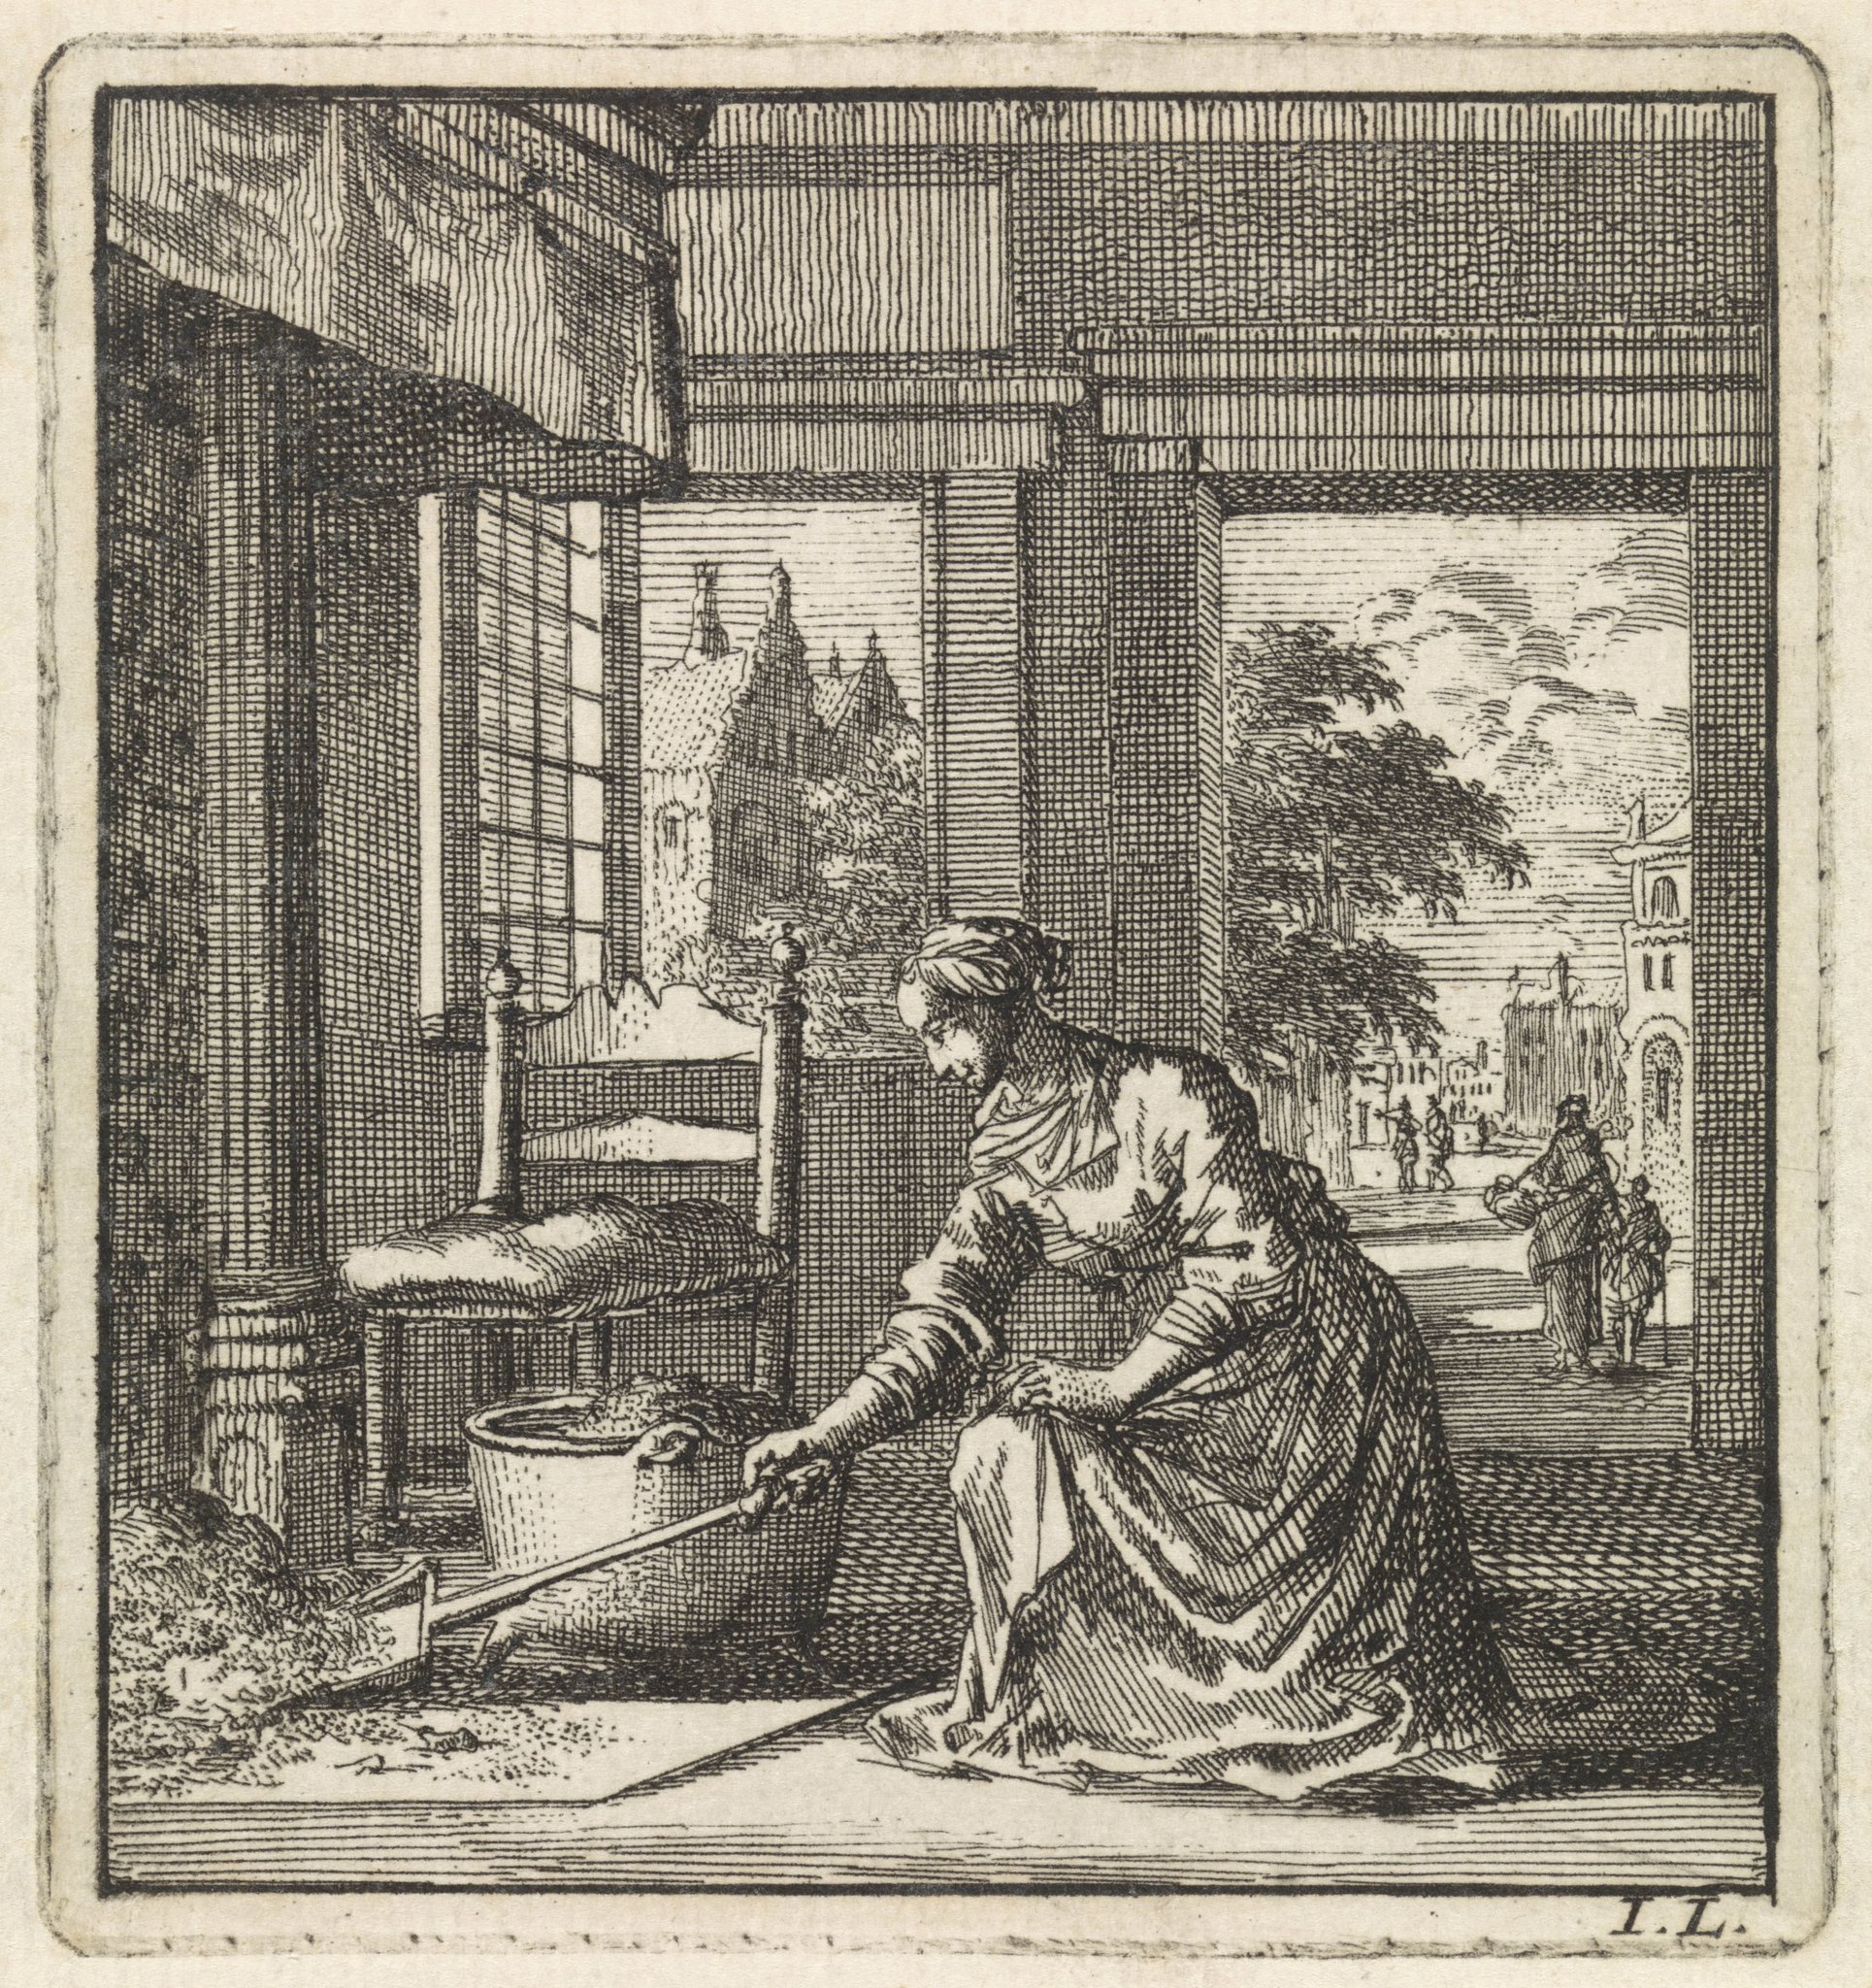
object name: book illustration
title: Vrouw schept de as uit de haard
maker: jan luyken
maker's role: draughtsman, print maker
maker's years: 1649-1712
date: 1711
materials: paper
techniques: etching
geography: amsterdam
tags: chimney, ash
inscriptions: collector's mark: Lugt 2228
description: Illustratie voor: Luyken, Jan. Het leerzaam huisraad, vertoond in vyftig konstige figuuren, met godlyke spreuken en stichtelyke verzen: Pieter Arentsz. II (wed.) en Cornelis van der Sys, 1711, p. 138.